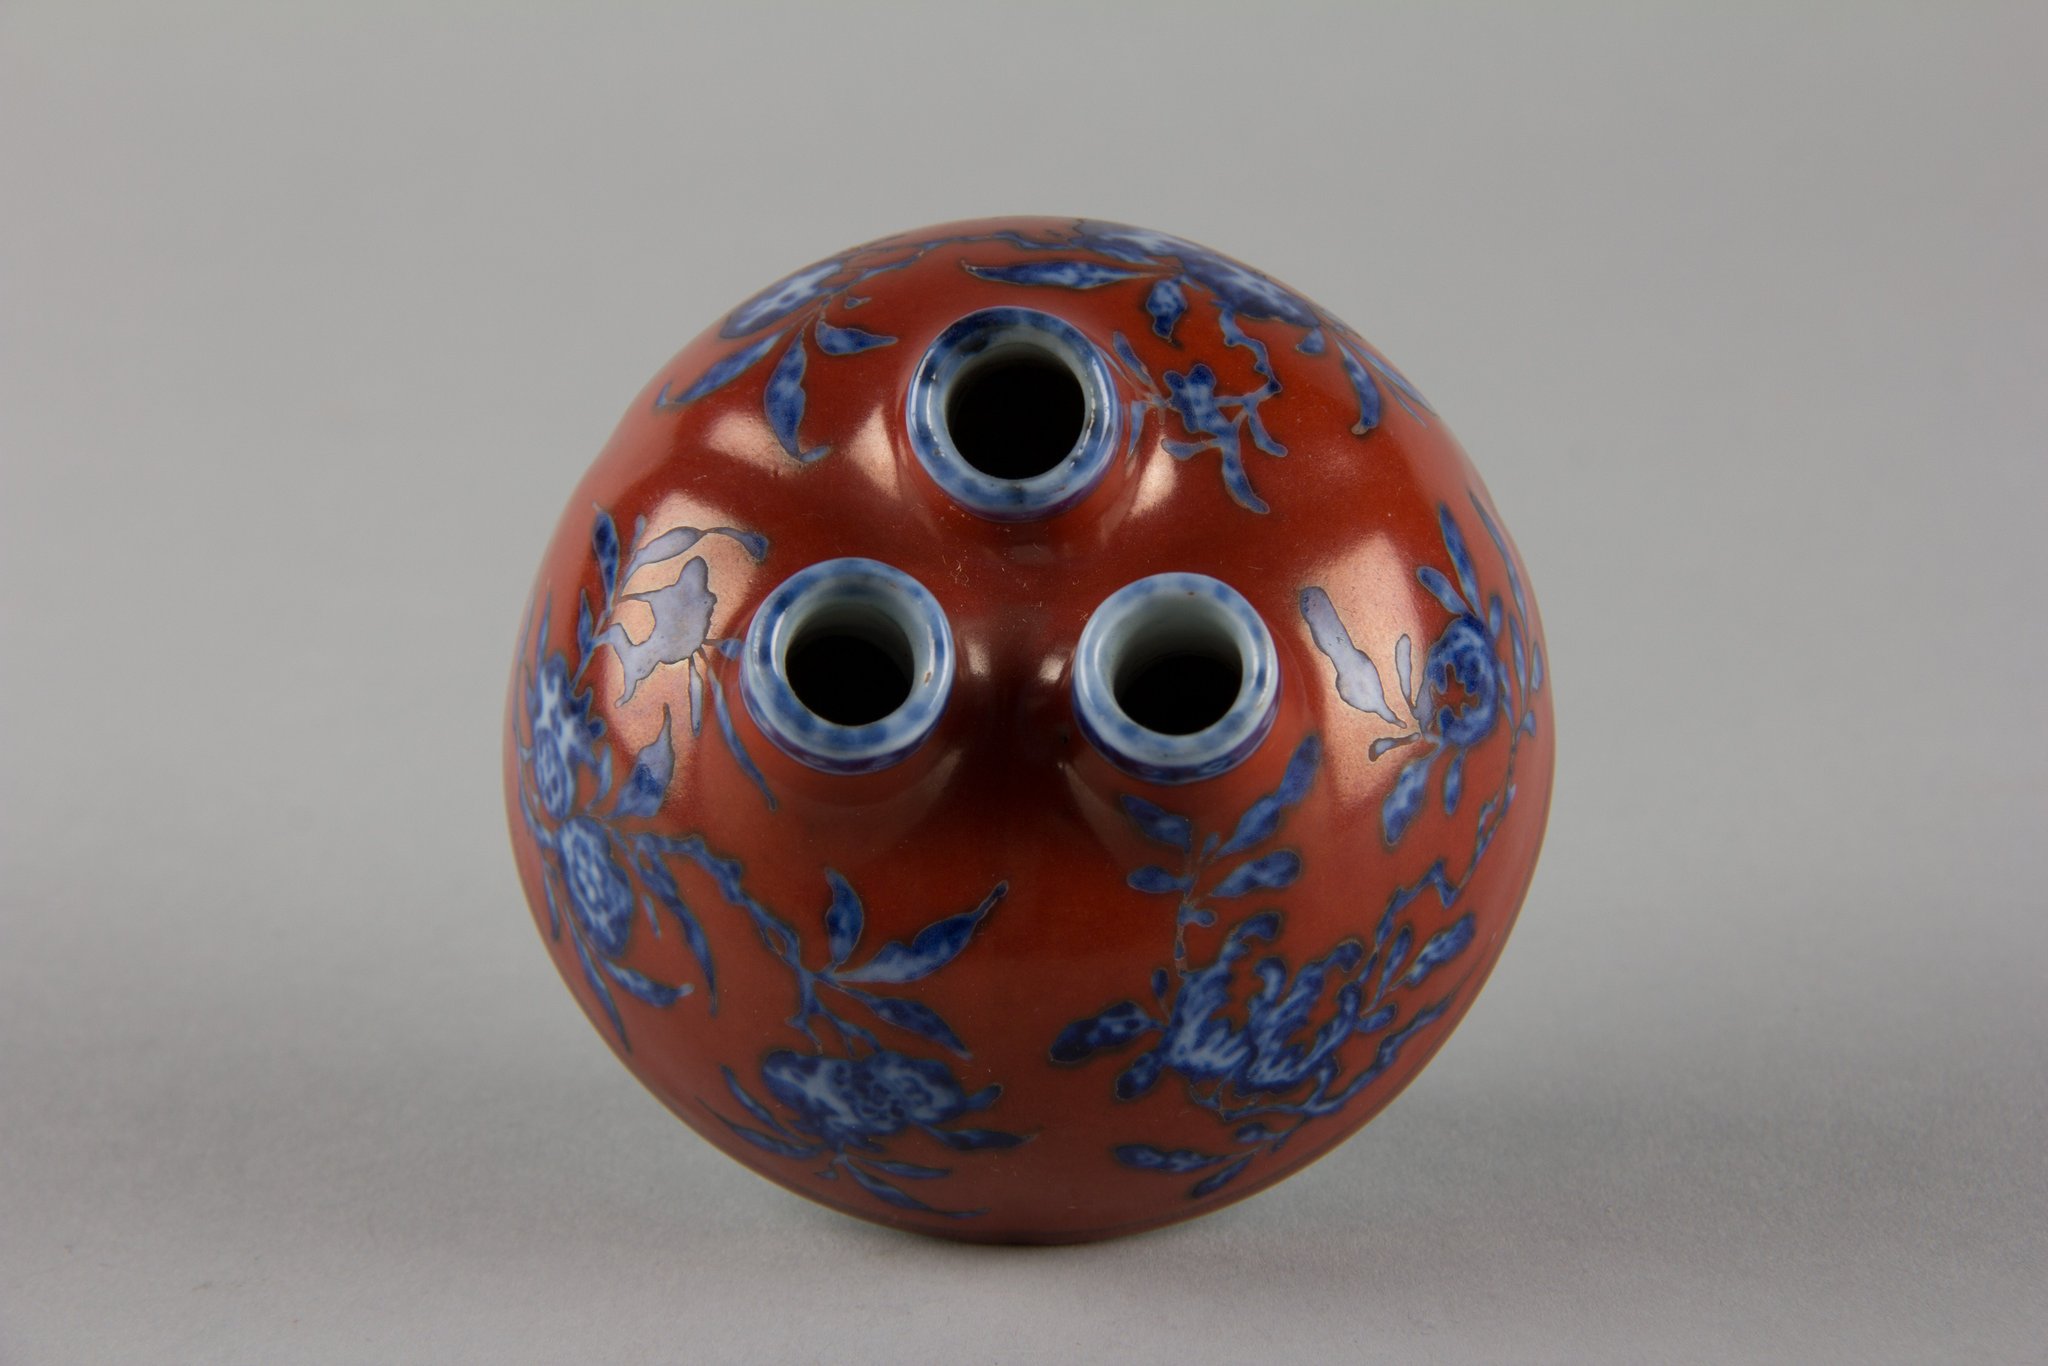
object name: ink well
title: Three-tubed vessel with peaches, pommegranades, and fingered citrons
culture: chinese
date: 1701-1800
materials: cobalt, enamel, iron, porcelain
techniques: overglaze, painting, underglaze